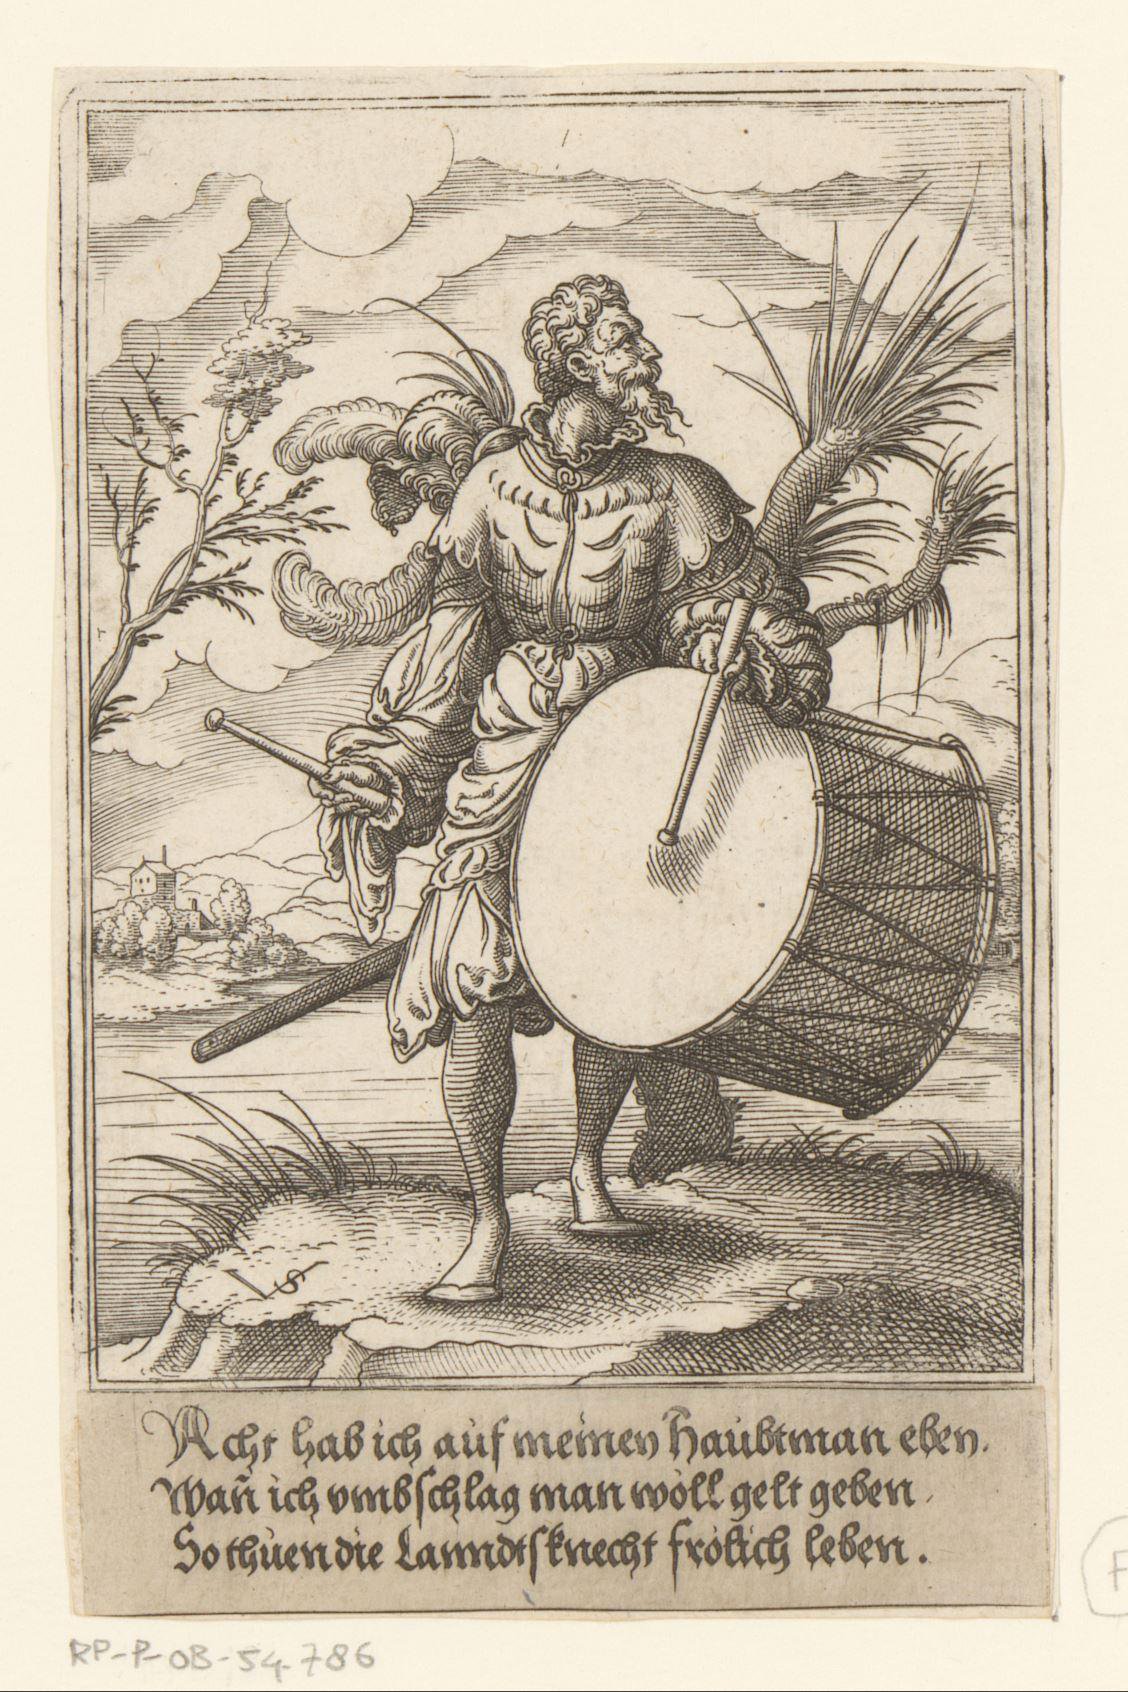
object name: print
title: Trommelaar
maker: virgilius solis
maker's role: draughtsman, print maker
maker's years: 1514-1562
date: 1524-1562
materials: paper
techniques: engraving, etching, intaglio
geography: nuremberg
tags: ranks in the army, the soldier; the soldier's life, drum (musical instrument) - cc - out of doors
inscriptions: number: ‘146’, collector's mark: Lugt 2228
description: Maakt deel uit van een serie van elf prenten met voorstellingen van militaire figuren. Een drieregelige Duitse tekst afkomstig van een onbekende andere prent is als onderschrift onder de voorstelling gemonteerd.